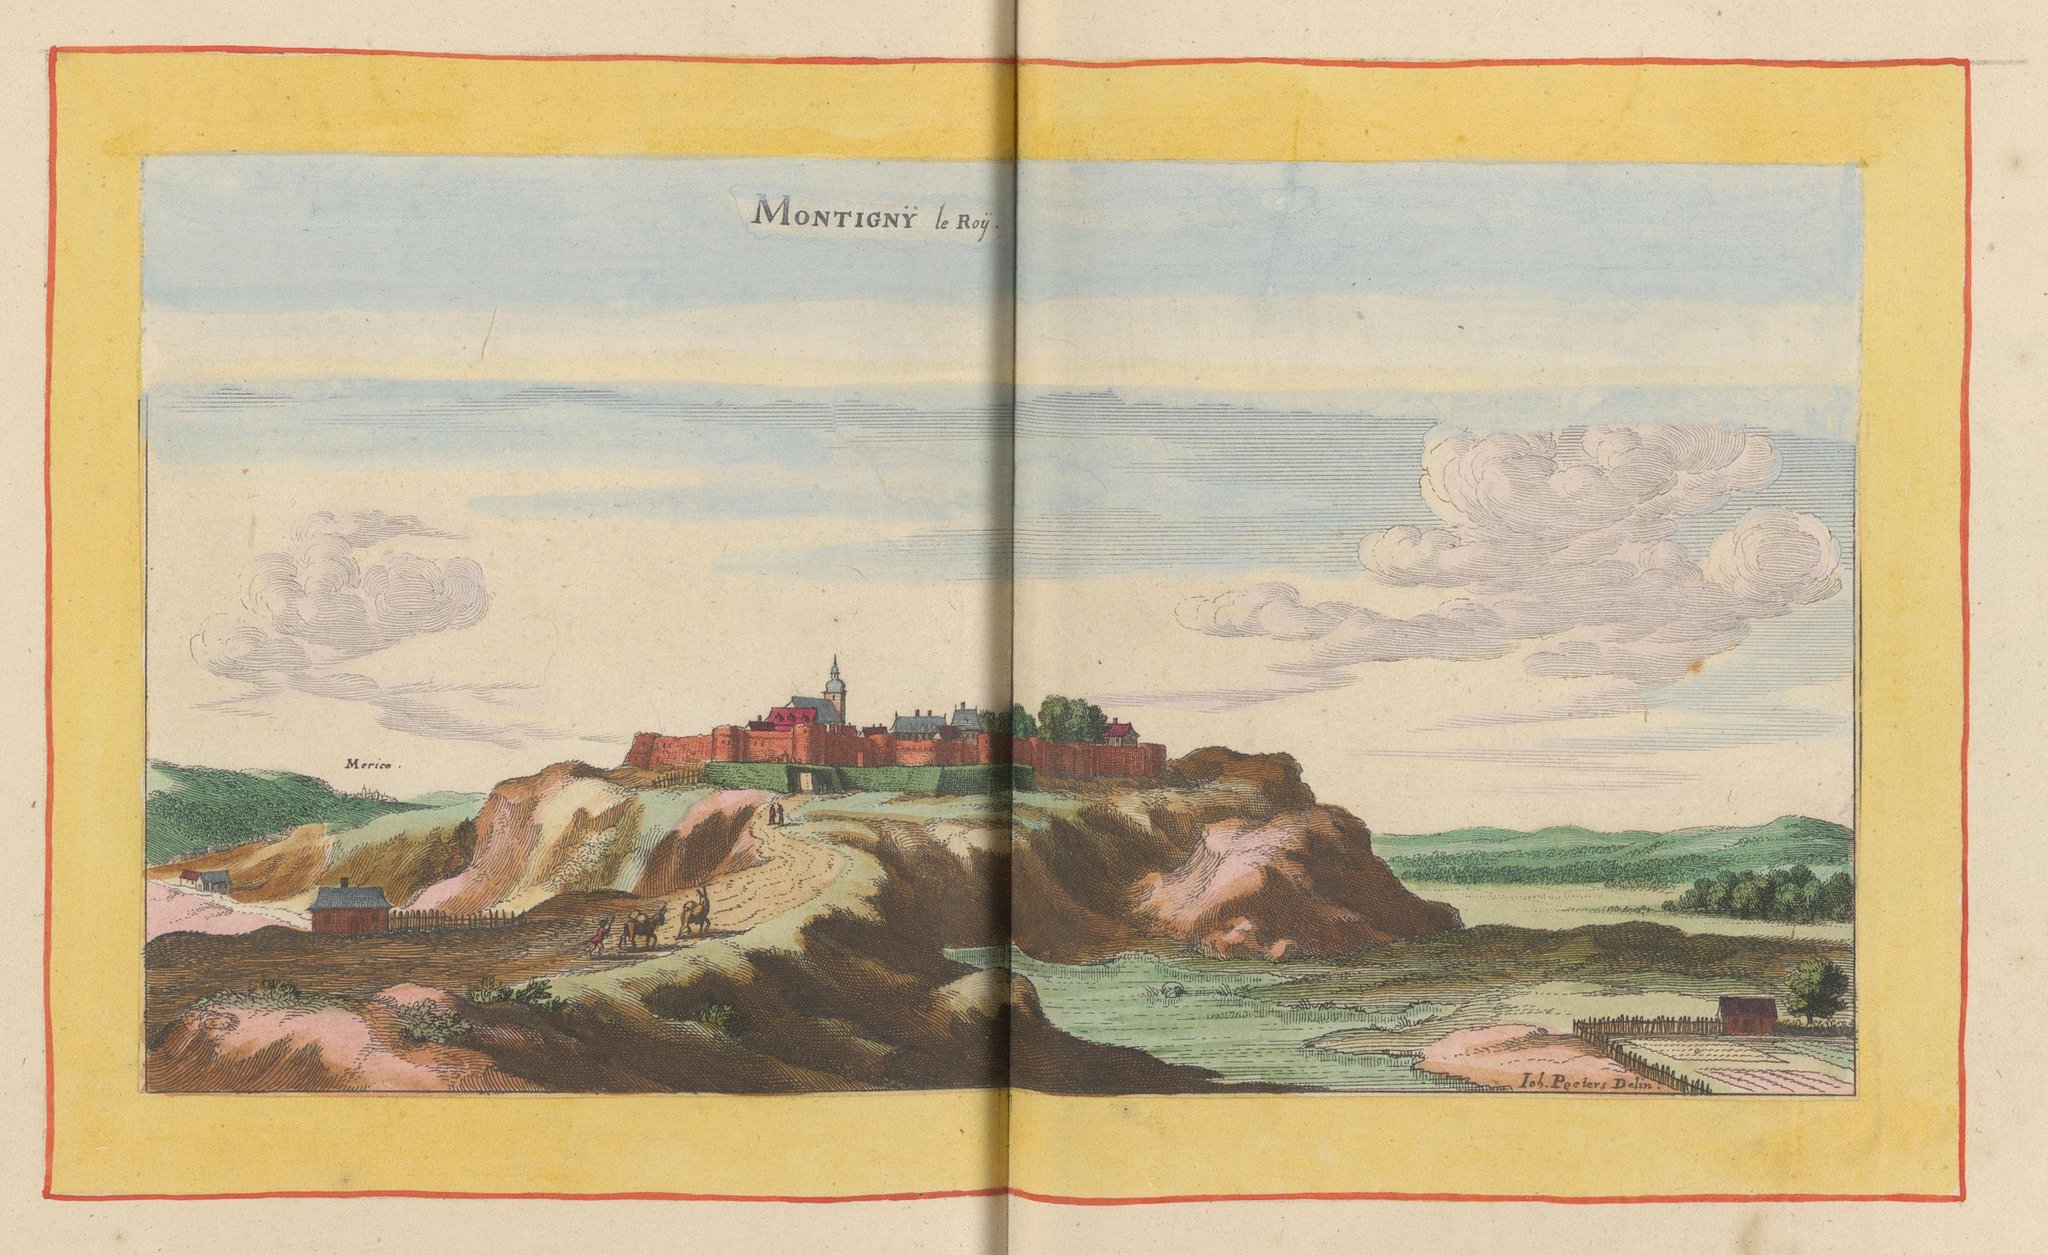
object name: album leaf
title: Gezicht op Val-de-Meuse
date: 1656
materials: paper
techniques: engraving, etching, hand coloring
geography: frankfurt am main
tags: city-view in general; 'veduta'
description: Prent uit: Zeiller, Martin. Topographia Galliae. 13 dln. Frankfurt: Caspar Merian, 1656, dl. 3, na p. 22. Origineel op één blad gedrukt met een gezicht op Monteclair (RP-P-1957-607-119-1).